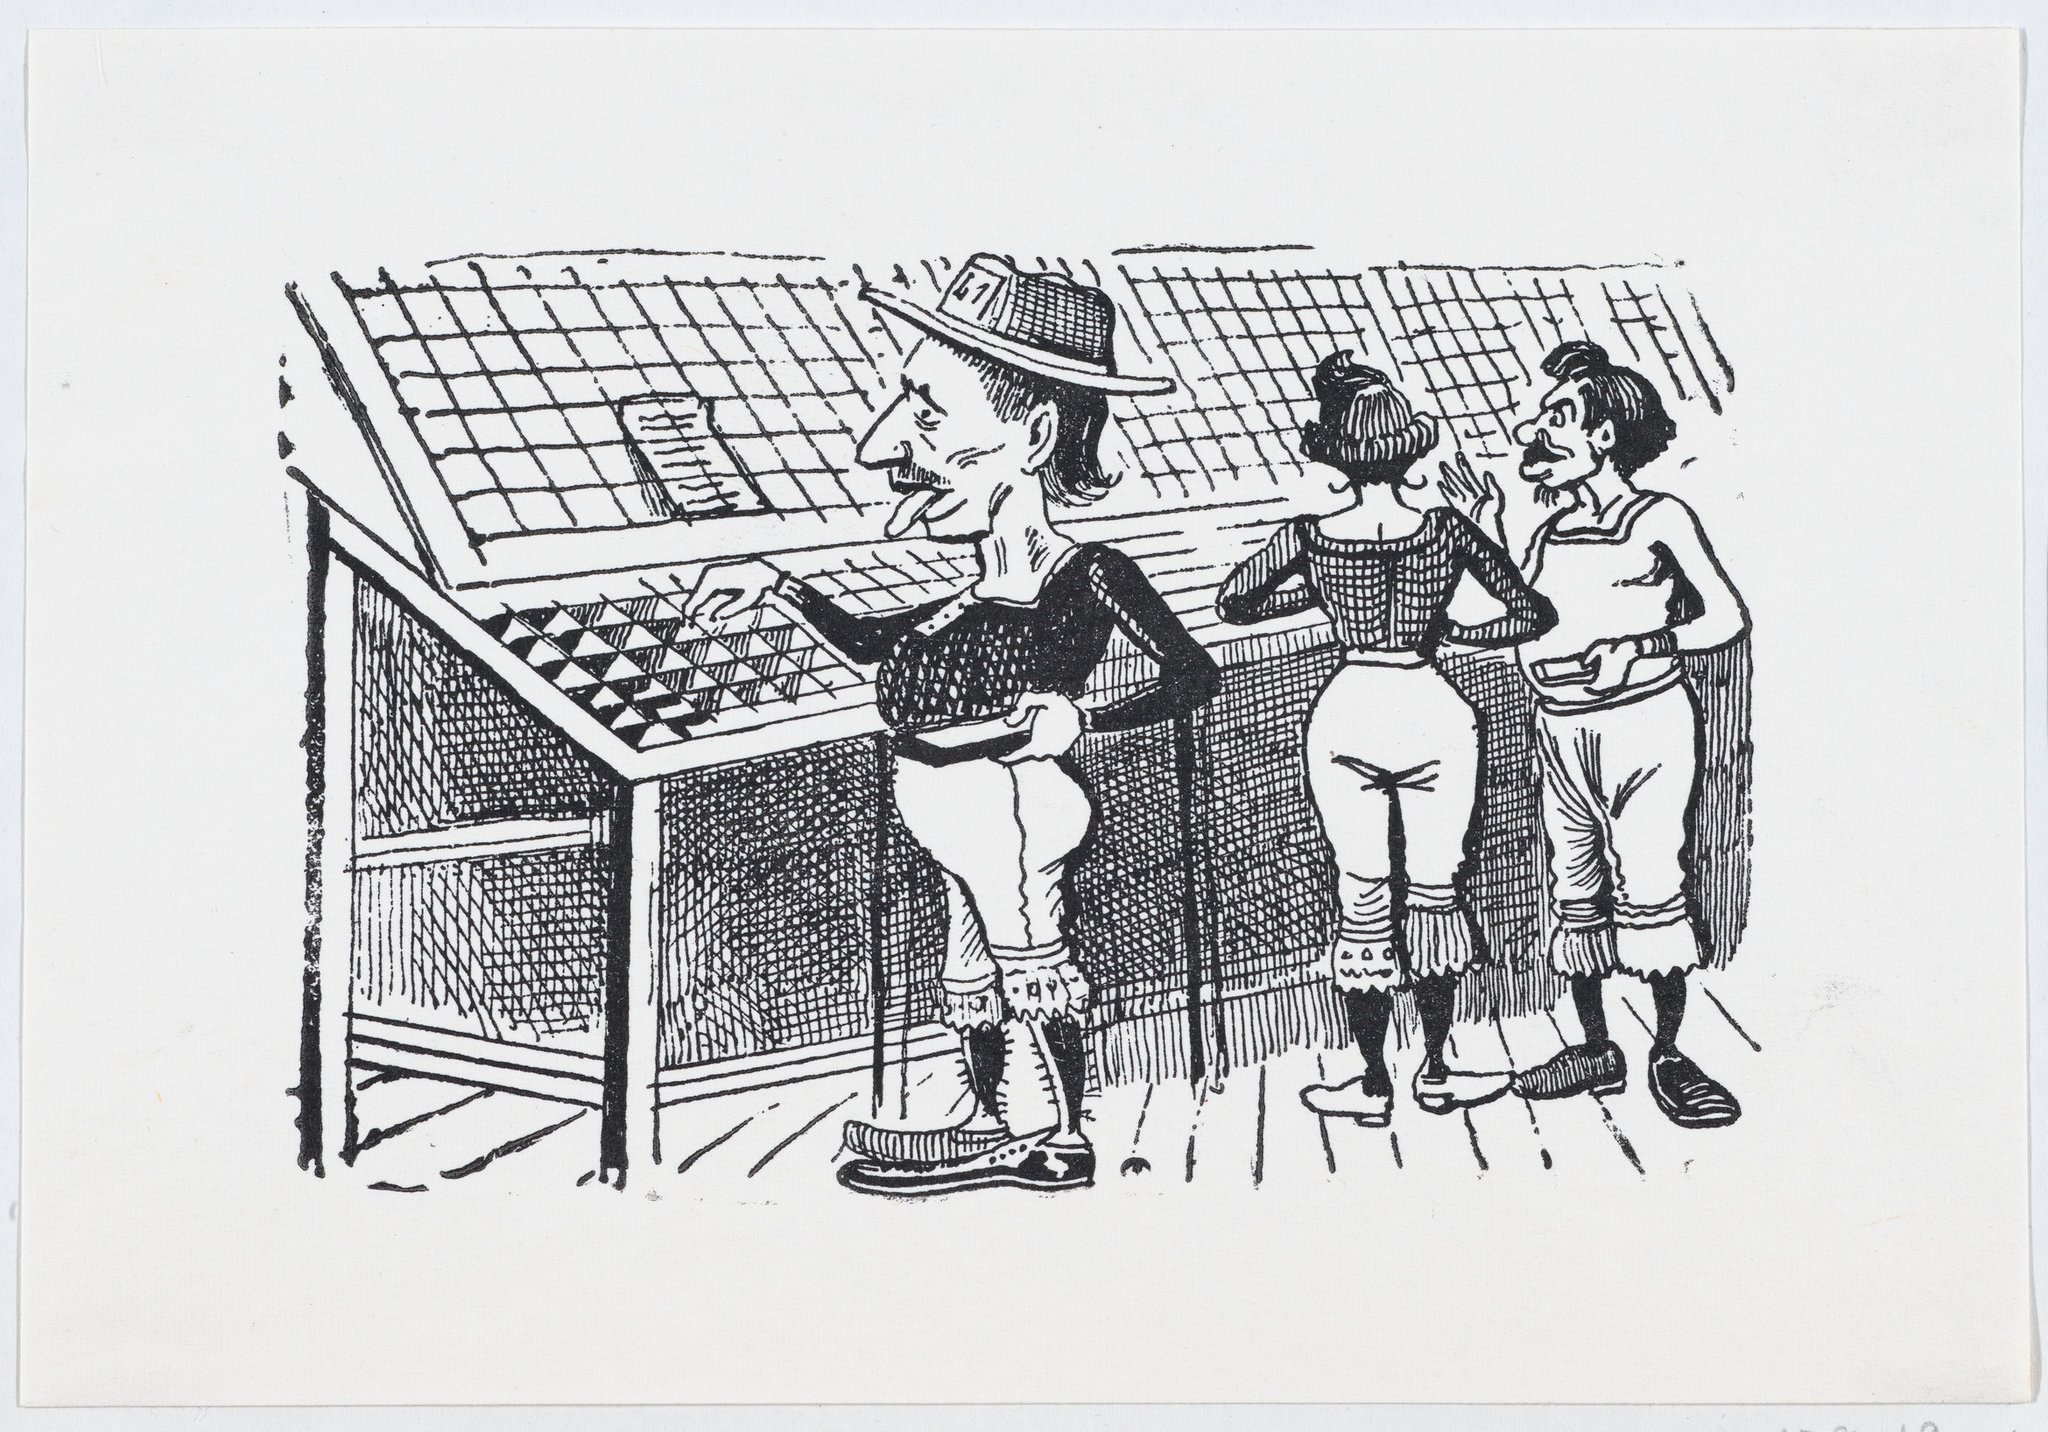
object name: print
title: A man wearing bloomers and a hat looking through merchandise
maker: josé guadalupe posada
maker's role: artist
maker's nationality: mexican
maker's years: 1852-1913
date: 1880-1910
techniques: lithography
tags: men,women